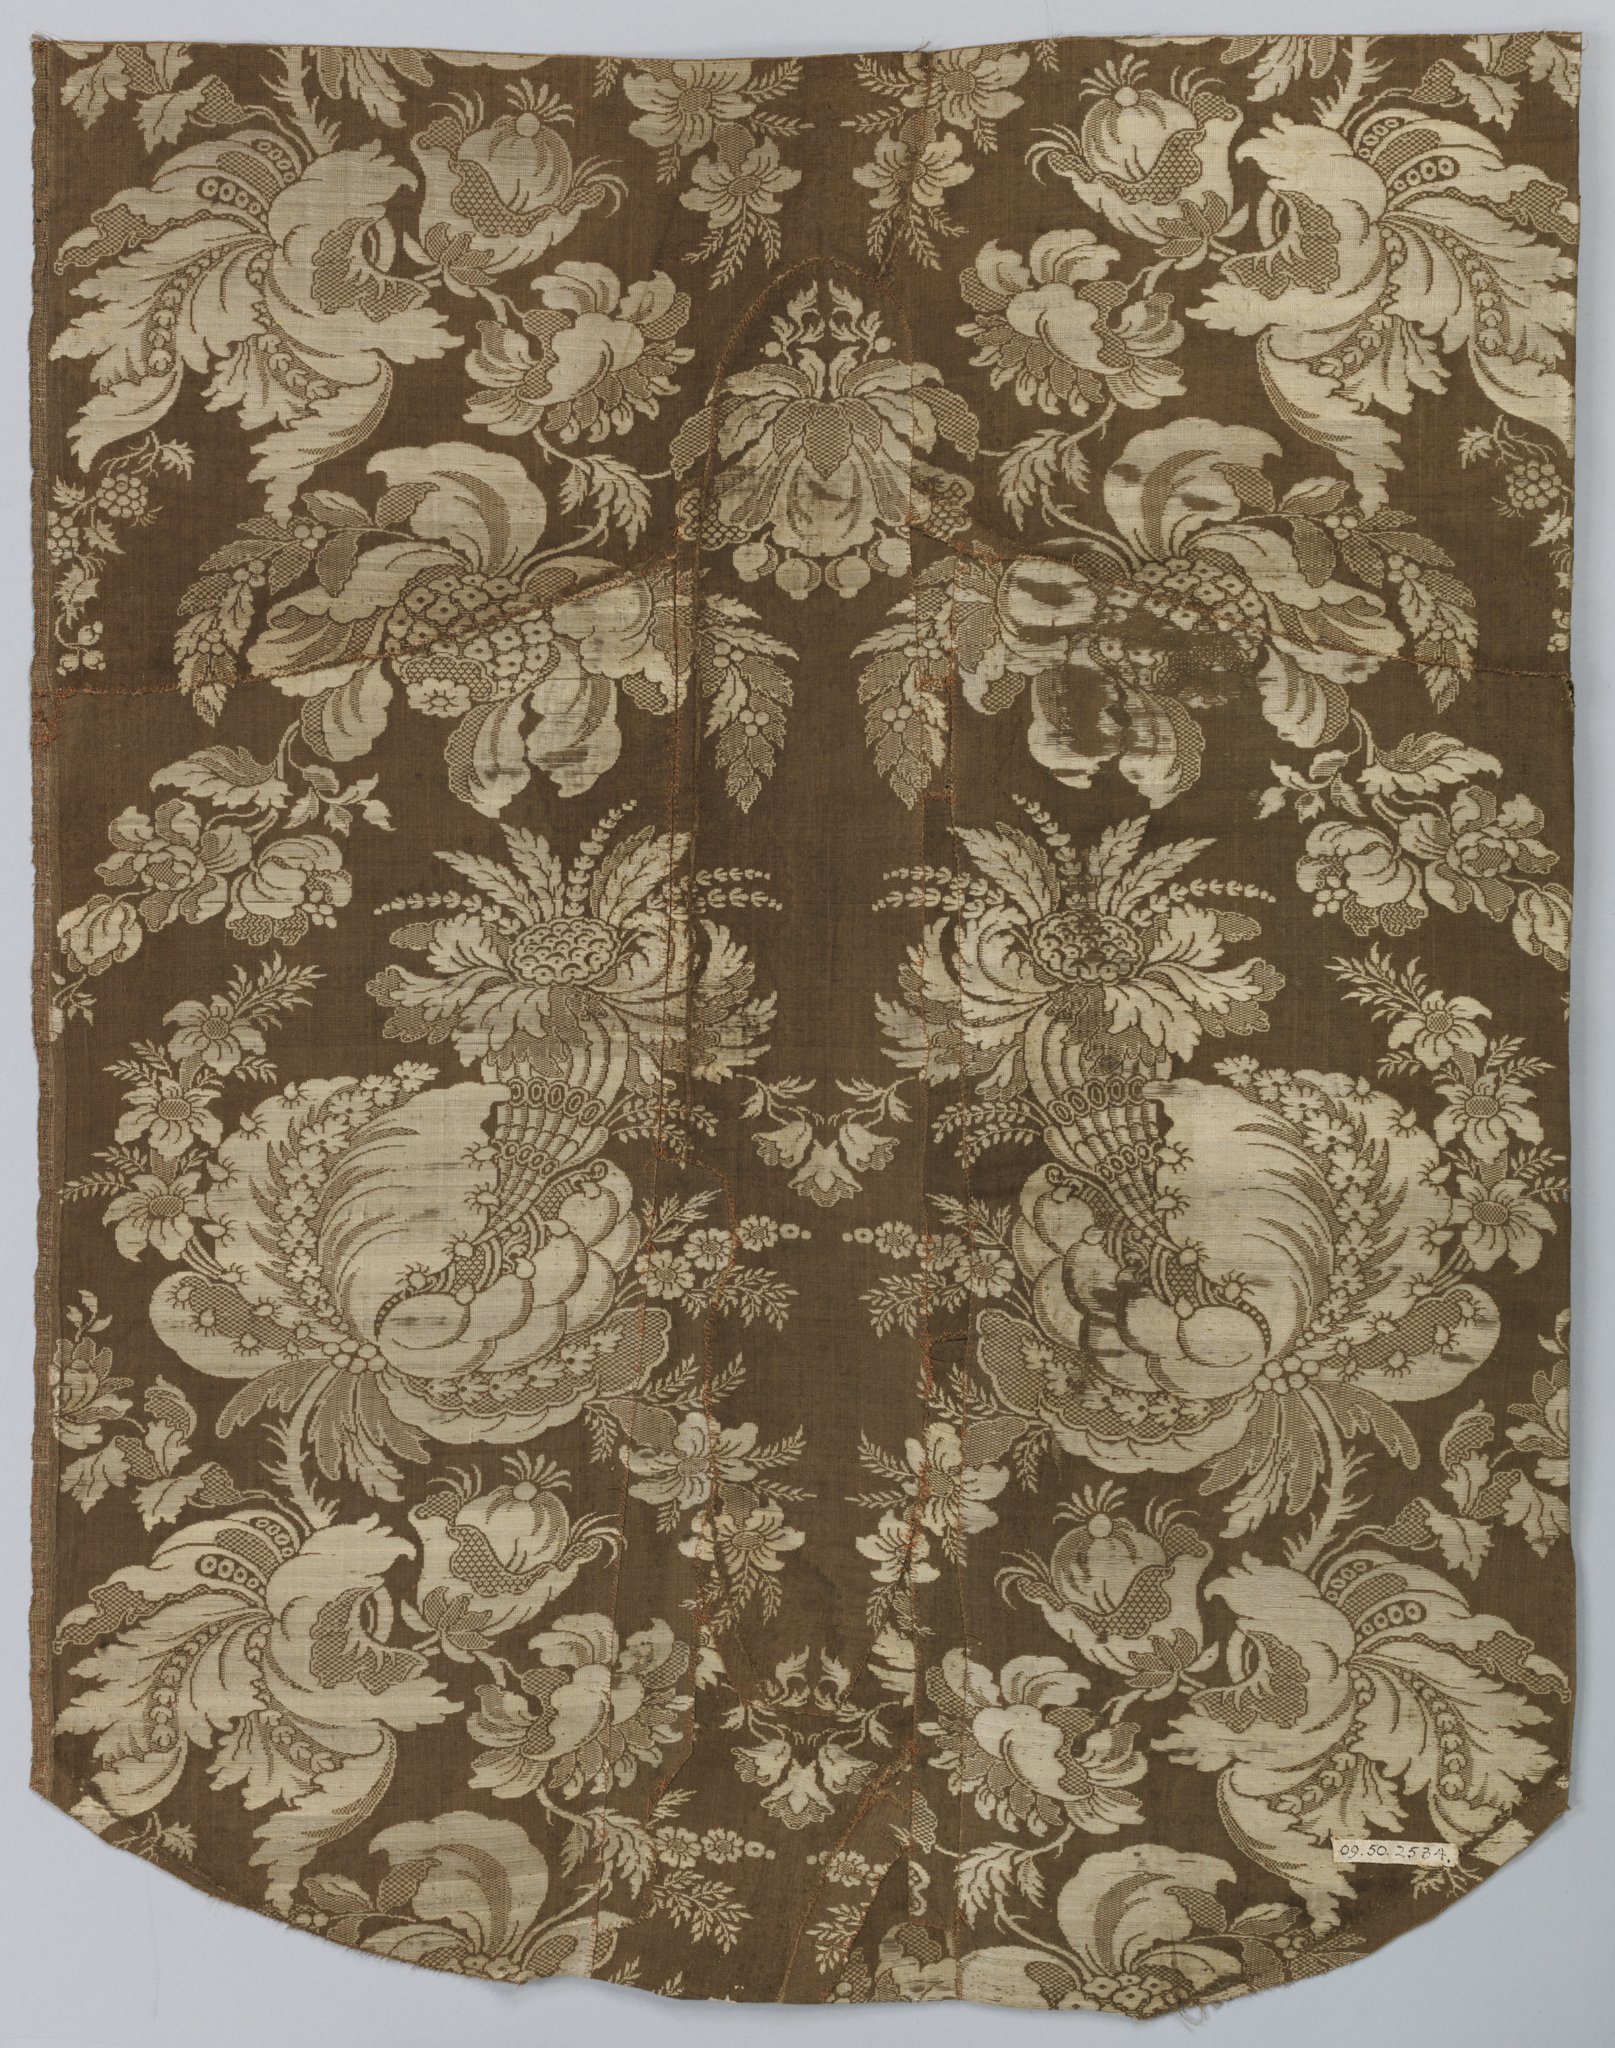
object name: silk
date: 1735-1750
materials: silk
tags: flowers,leaves